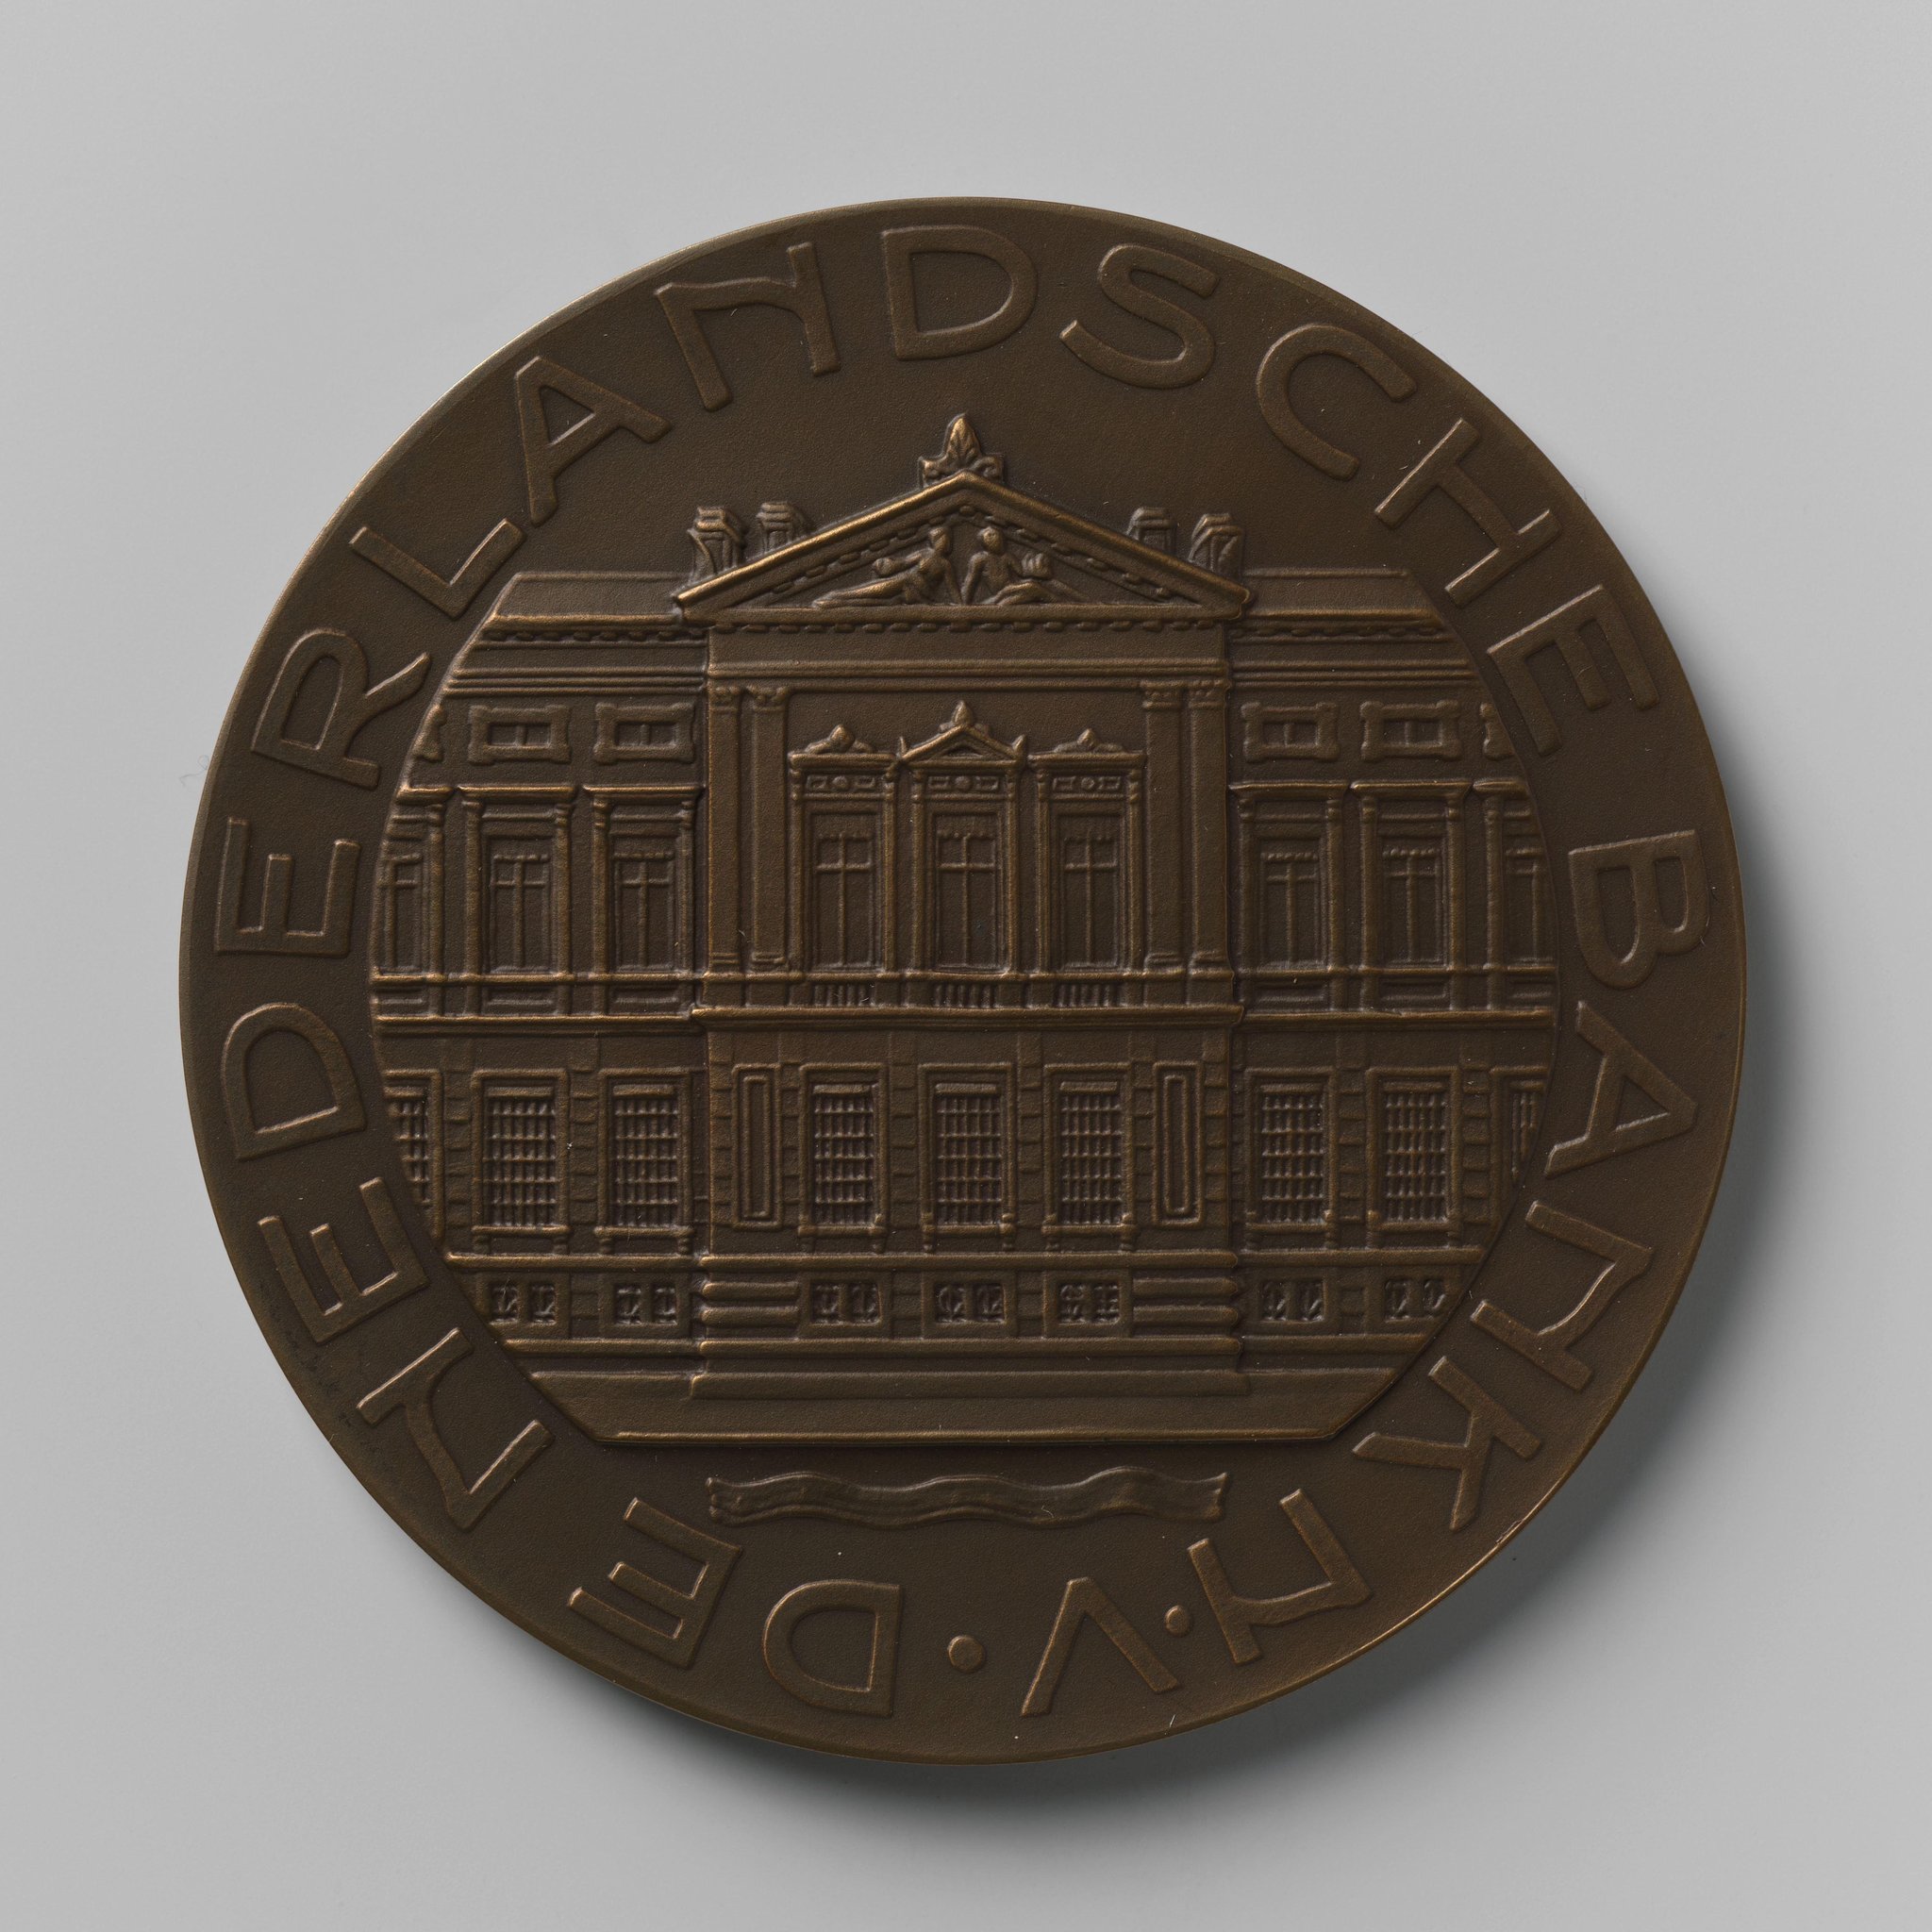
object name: history medal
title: Vijftigjarig bestaan van het Verzekeringsfonds van Beambten van de Nederlandsche Bank 1936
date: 1936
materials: bronze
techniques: striking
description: Bronzen penning, op de voorzijde het aanzicht van het bankgebouw met omschrift, op de keerzijde een rechthoekig veld met vijf regels tekst, versierd met de wapenschilden van Amsterdam en Rotterdam, alles binnen een krans van zeventien gemeentelijke wapenschilden.